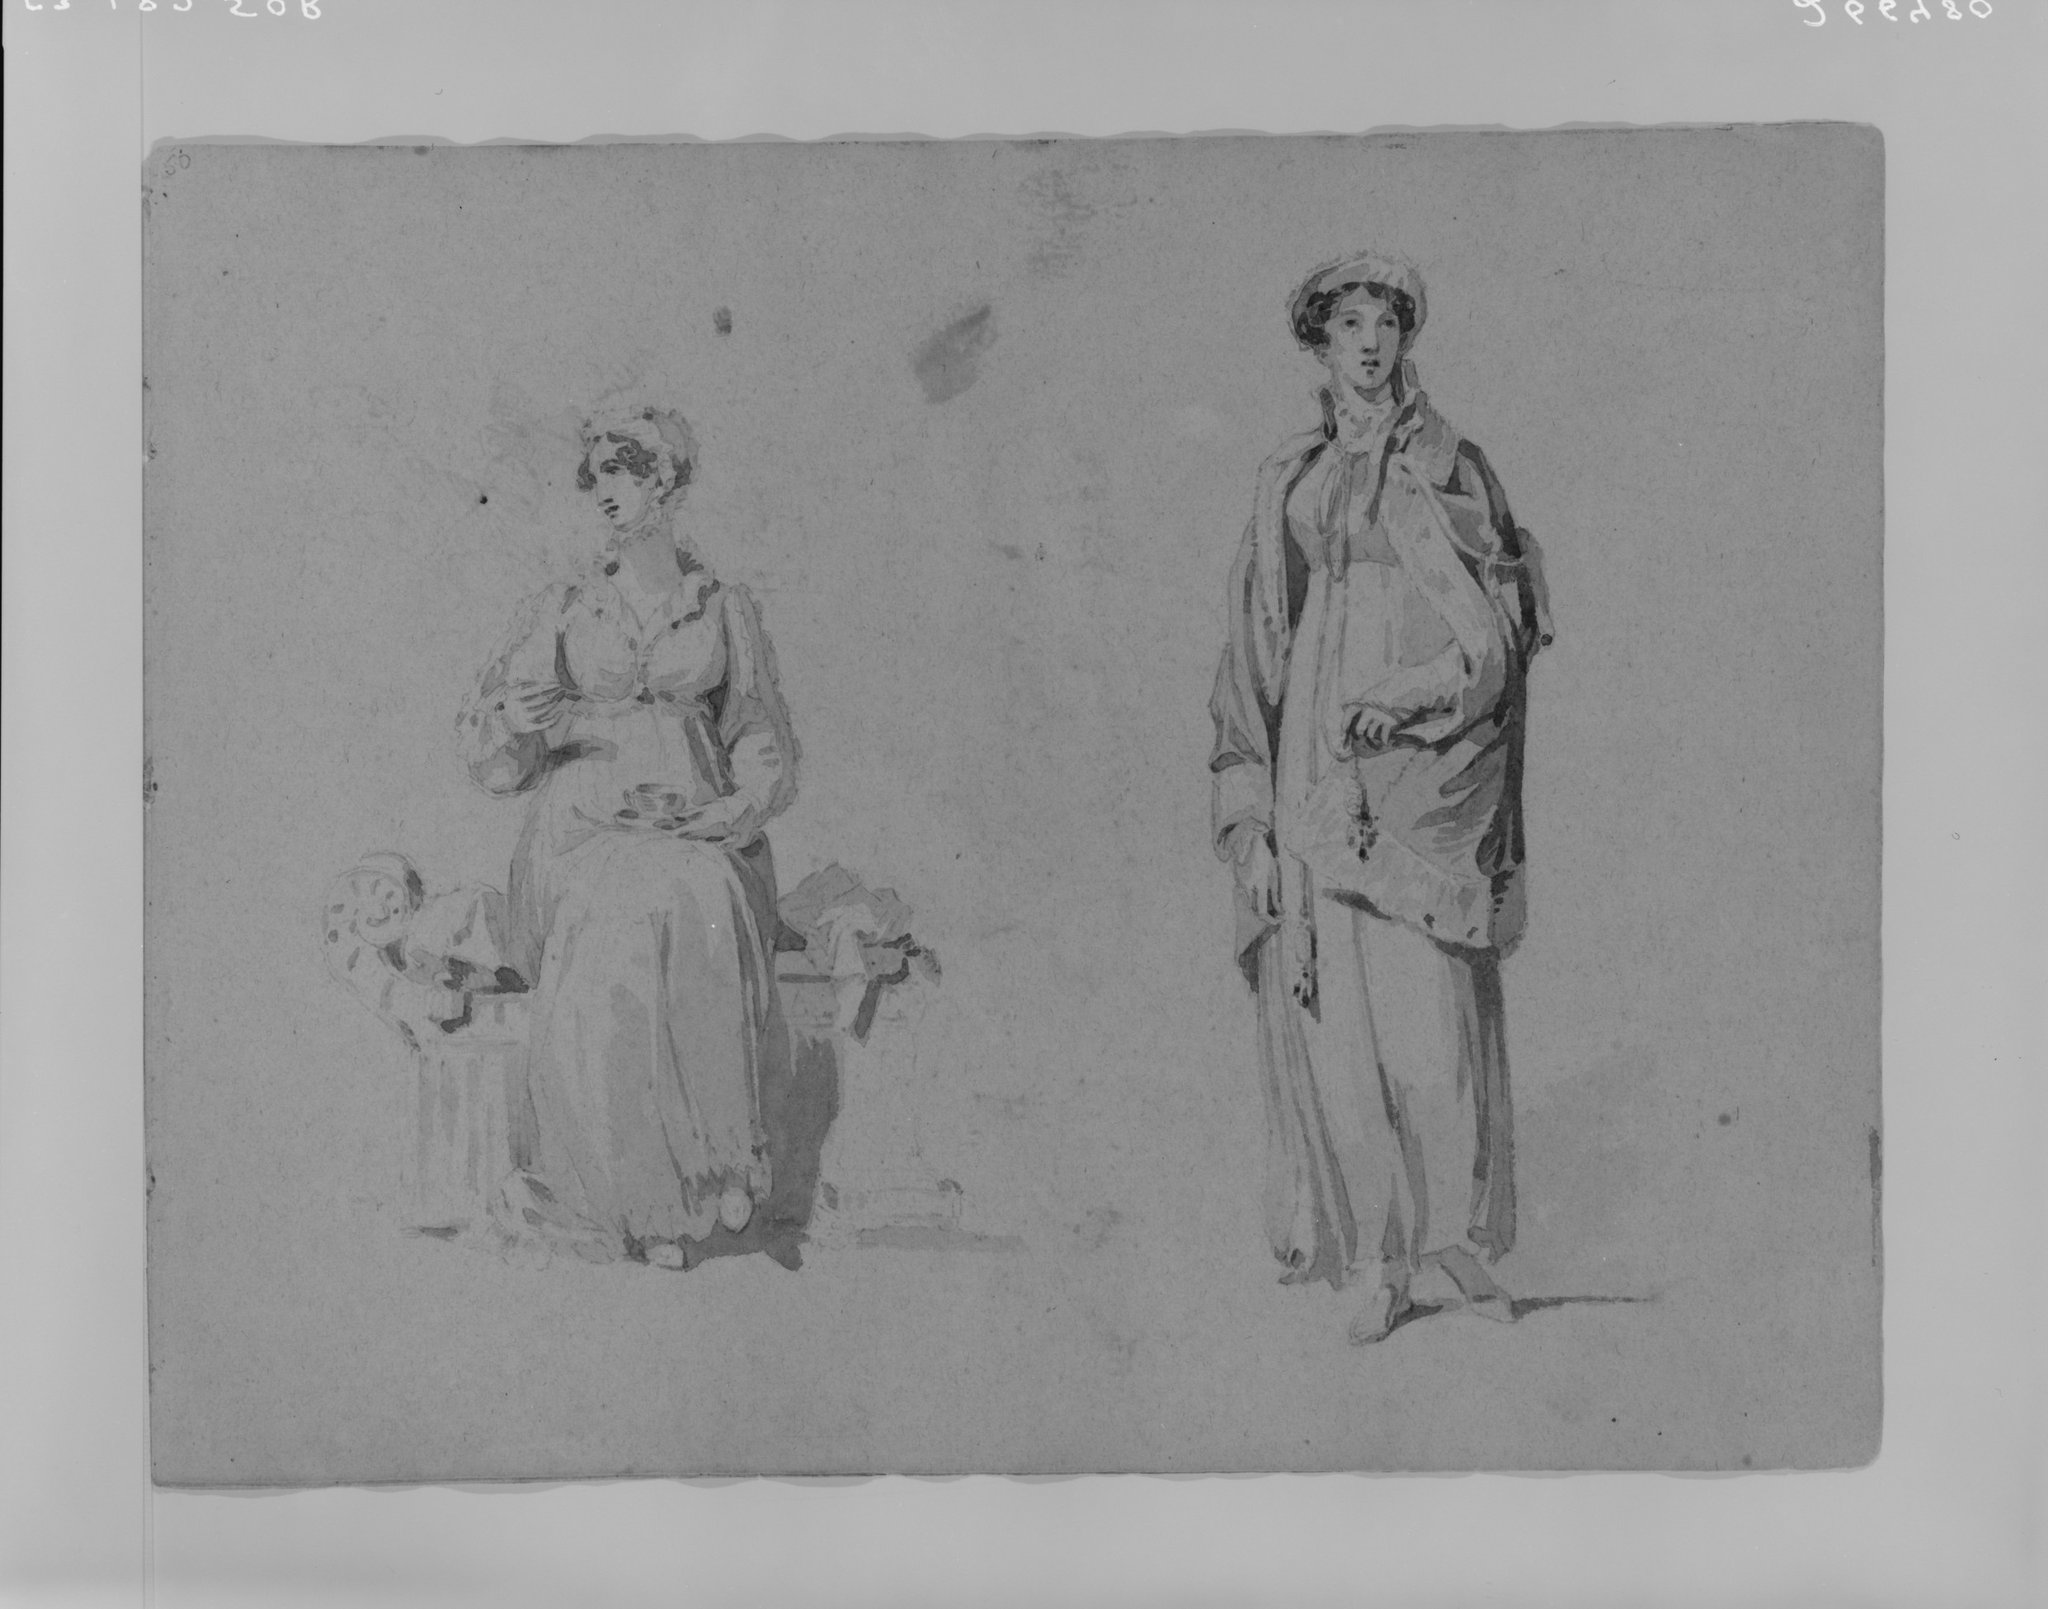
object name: drawing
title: (From Sketchbook)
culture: american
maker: thomas sully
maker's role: artist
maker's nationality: american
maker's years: 1783-1872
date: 1810-1820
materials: ink, paper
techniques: wash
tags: portraits,women